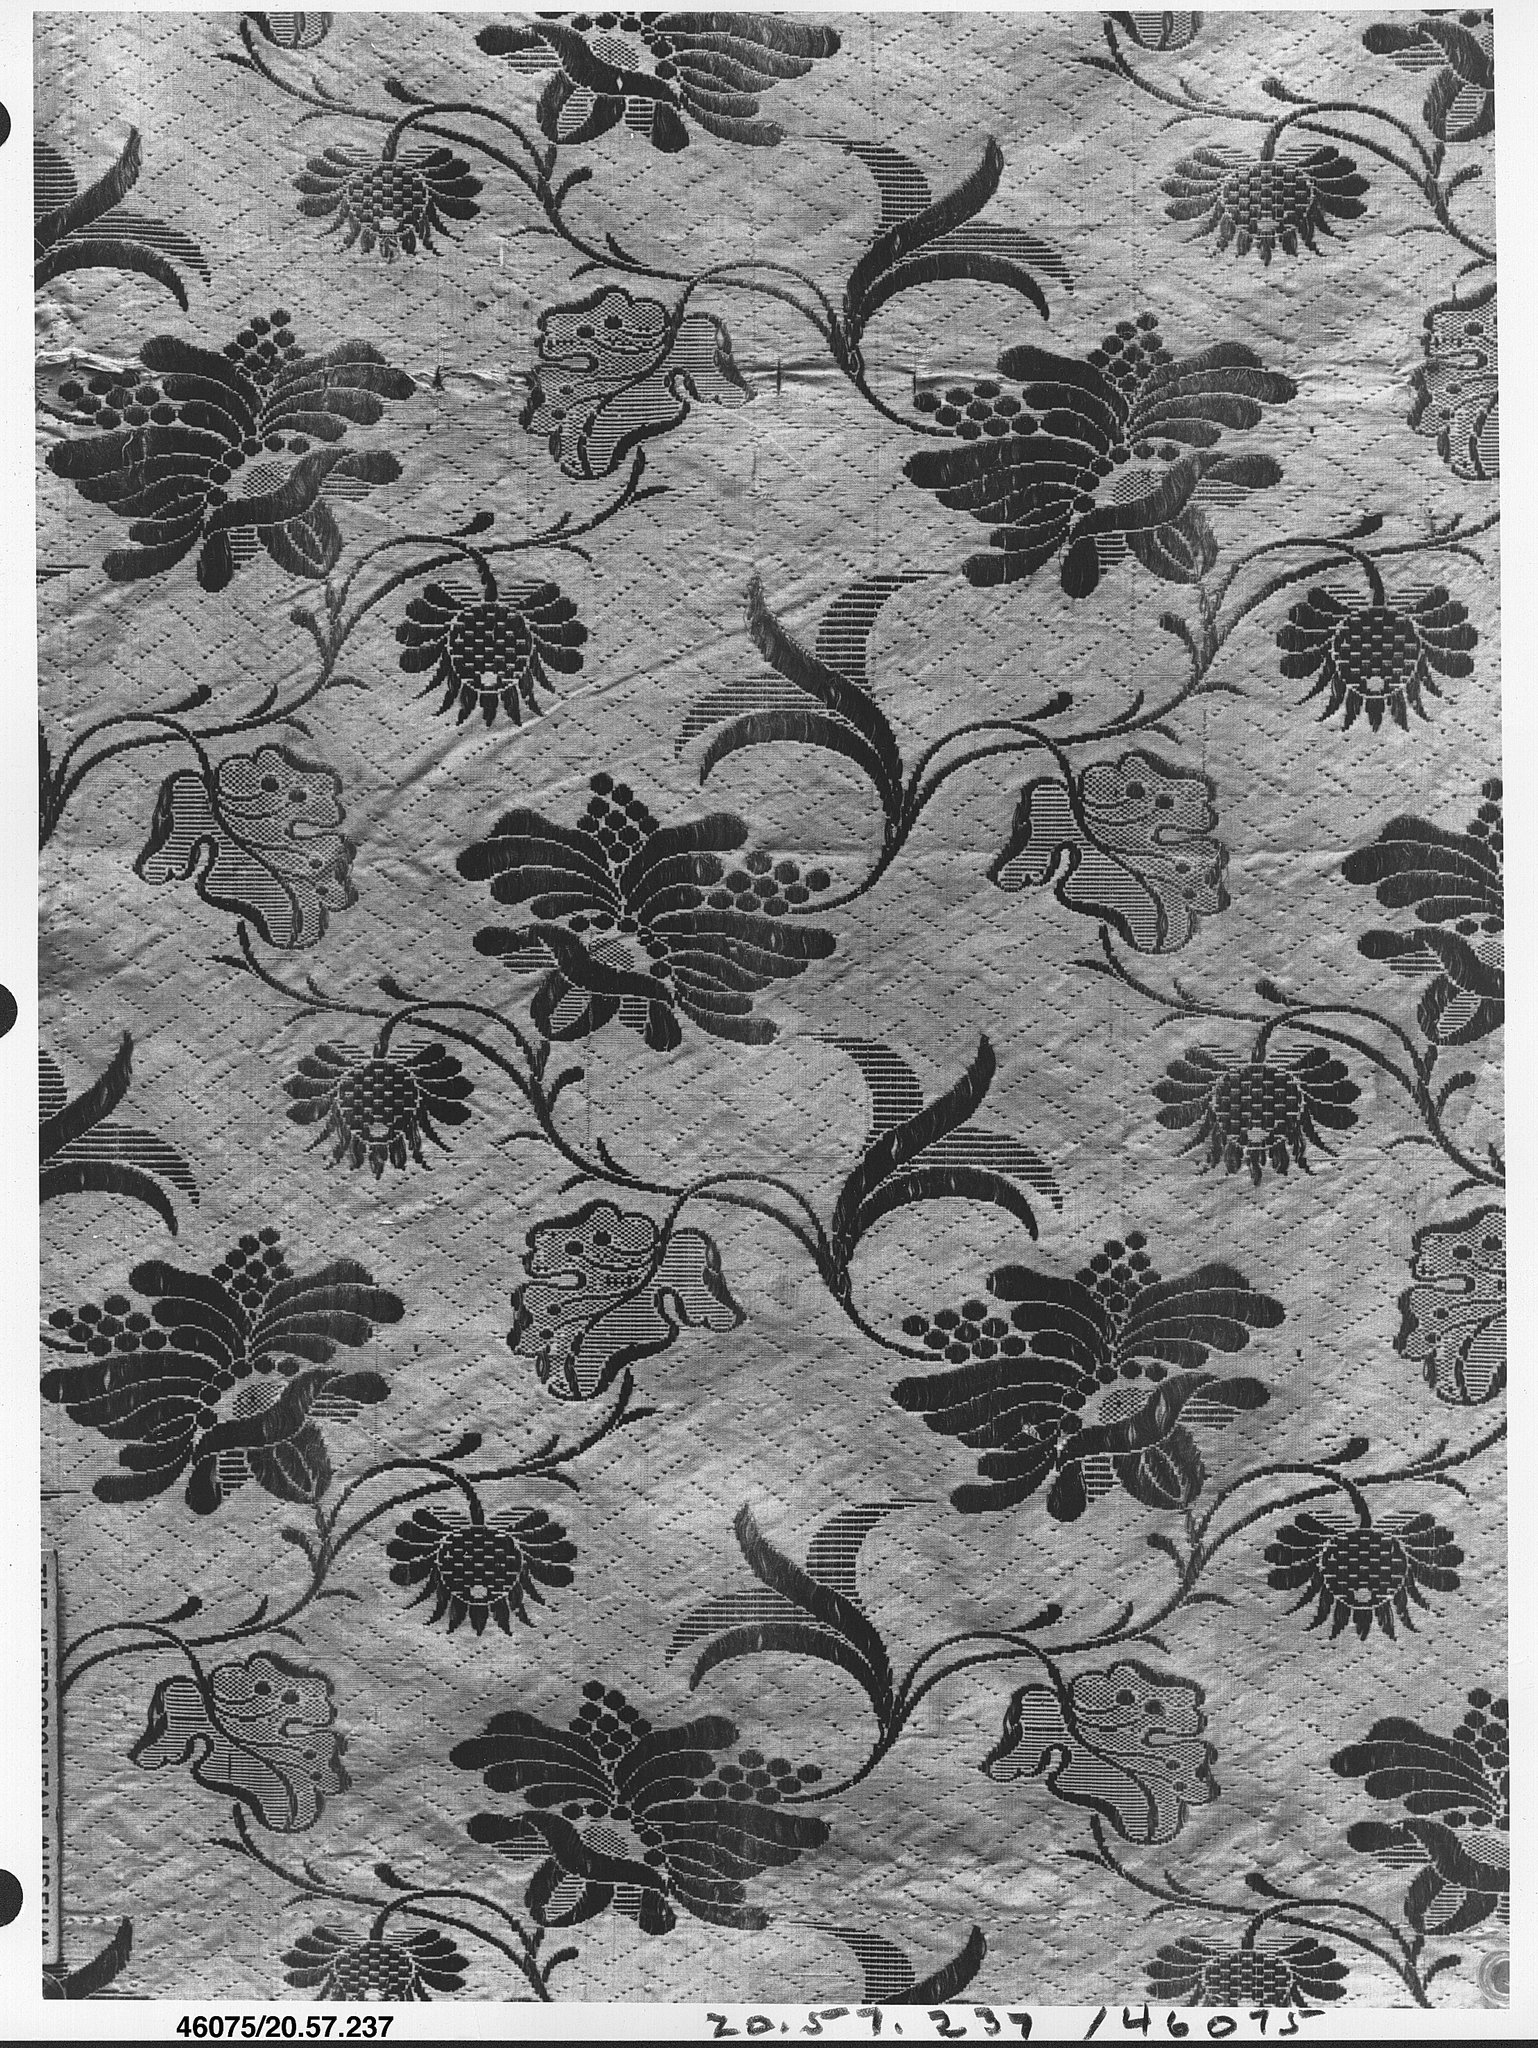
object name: piece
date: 1701-1800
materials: silk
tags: flowers,leaves